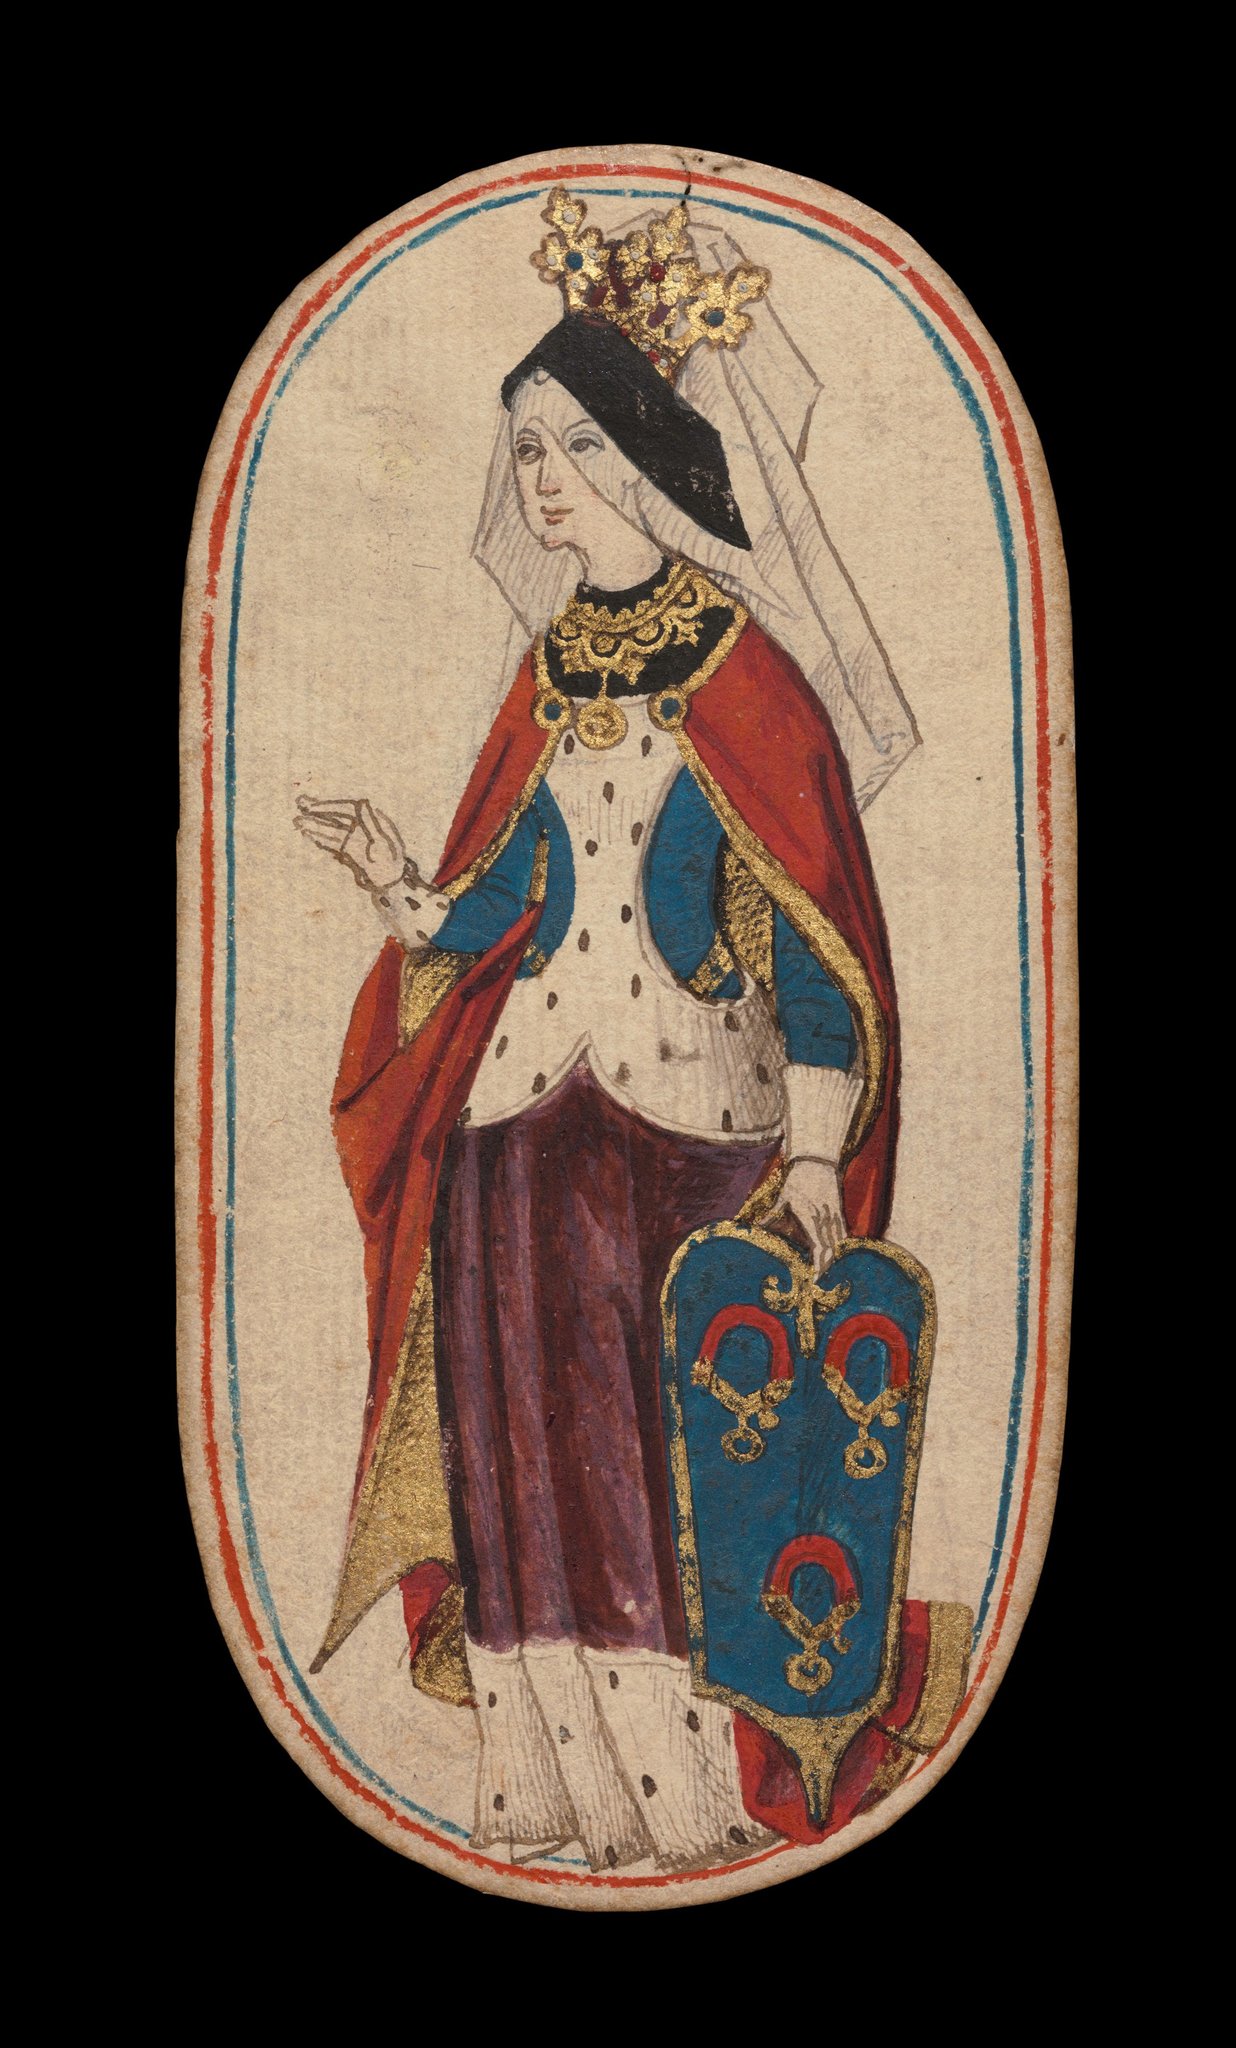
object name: playing card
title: Queen of Collars, from The Cloisters Playing Cards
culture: south netherlandish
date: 1475-1480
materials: glaze, gold, ink, paint, paper, silver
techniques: pen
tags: queens,playing cards,games